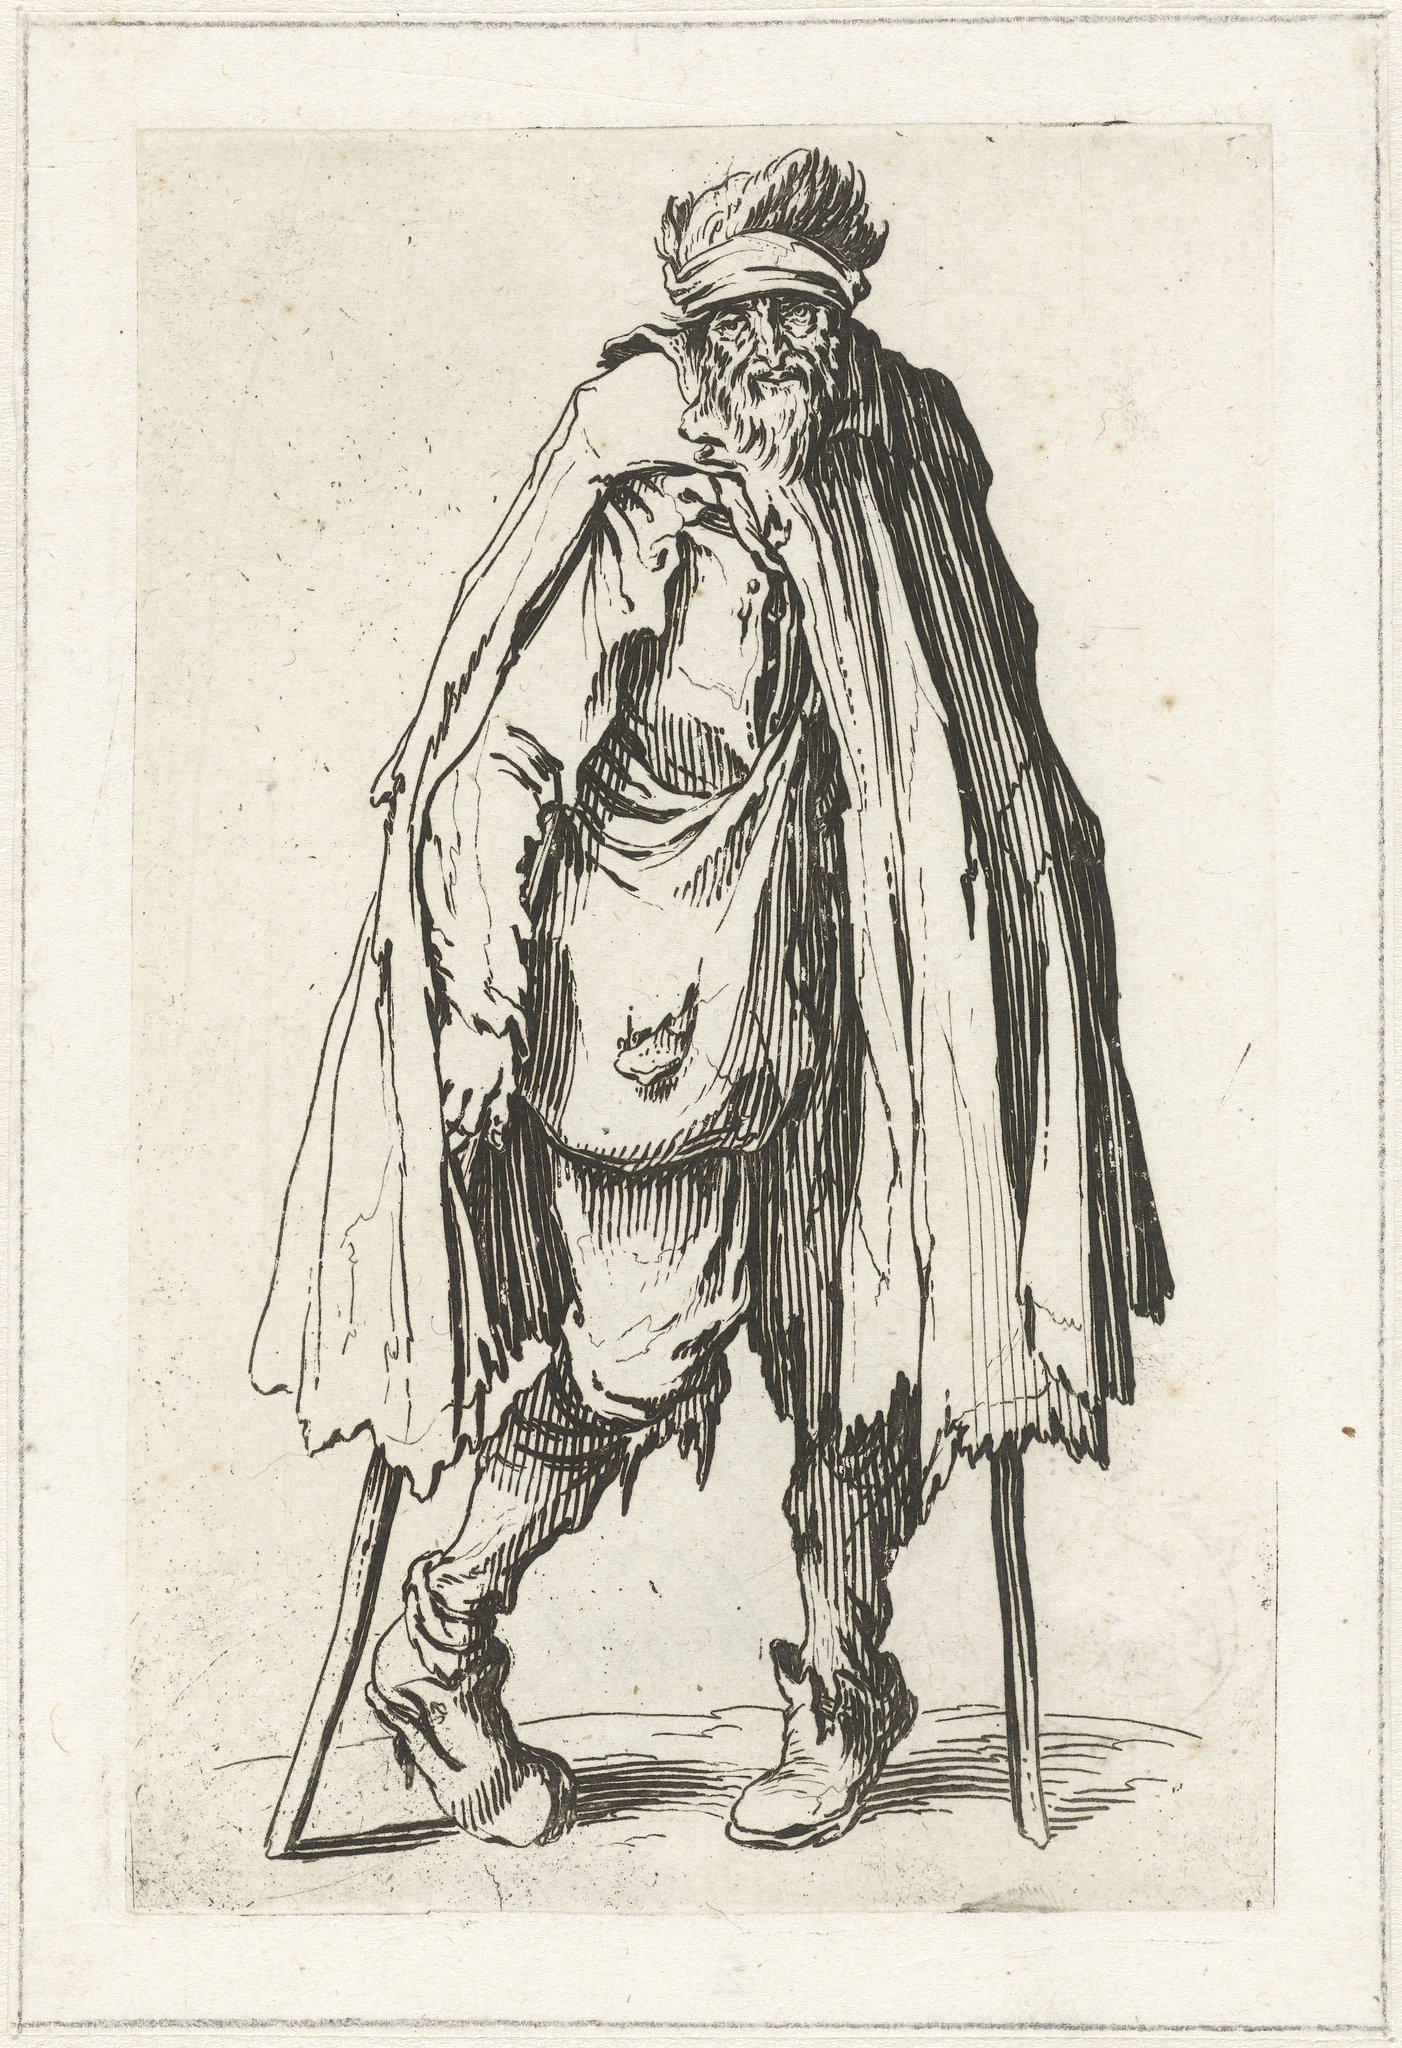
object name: print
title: Les Gueux / Les Mendiants / Les Baroni / Les Barons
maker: jacques callot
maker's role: draughtsman, print maker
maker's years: 1592-1635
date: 1622-1623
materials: paper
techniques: etching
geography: nancy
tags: crutches, beggar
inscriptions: collector's mark: Lugt 240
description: Man, gekleed in lompen, van voren gezien, steunend op twee krukken. Deze prent is onderdeel van een serie van 25 prenten met bedelaars en zwervers, zoals Callot die waarschijnlijk in Italië heeft gezien.